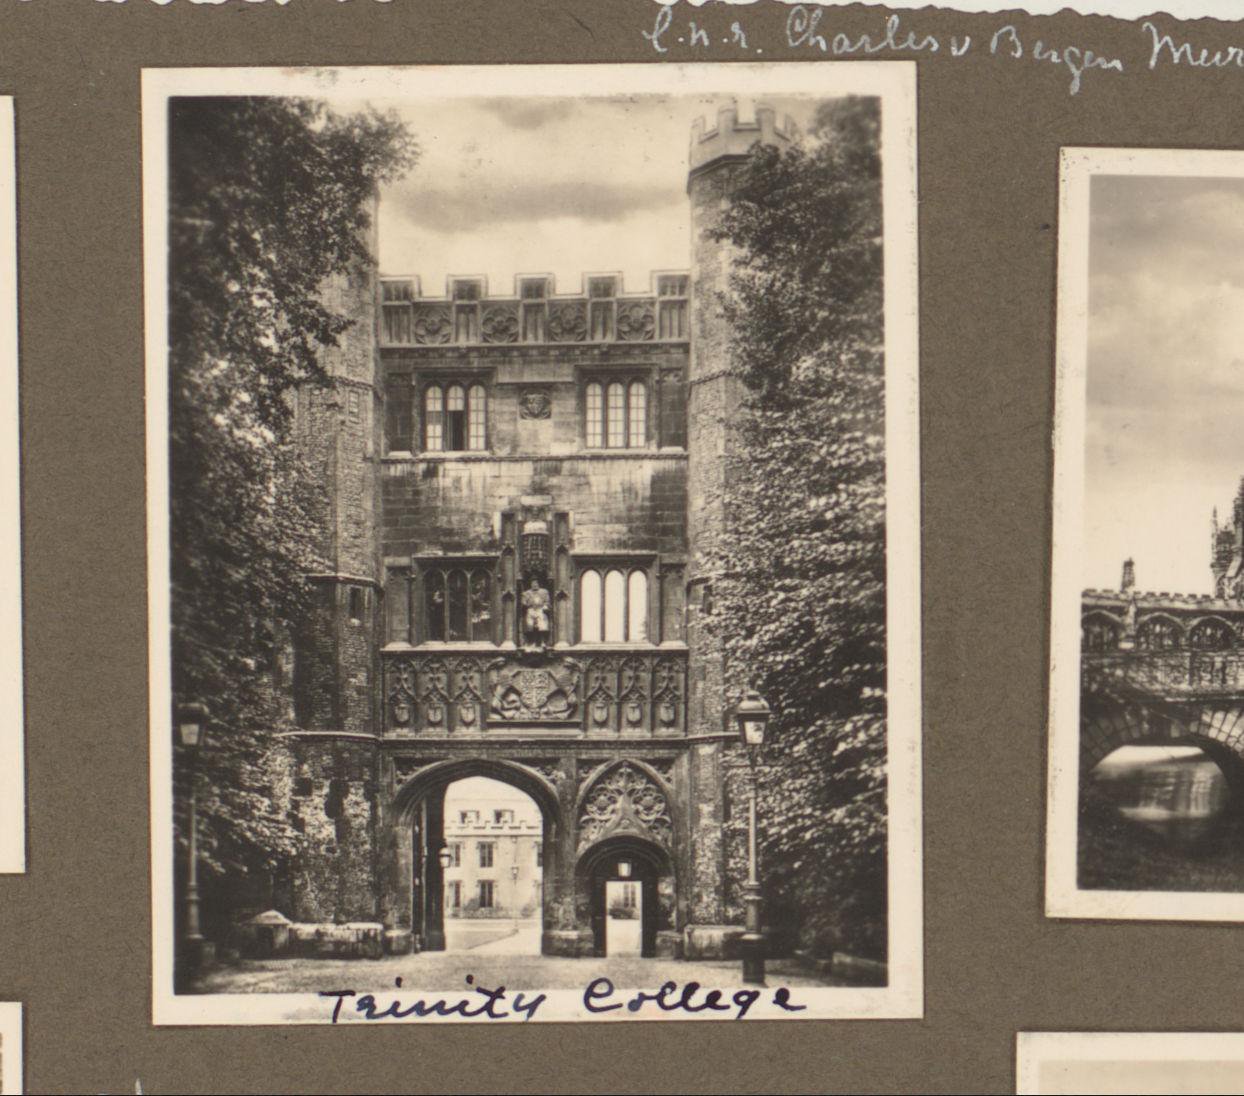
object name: photograph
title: Poort van Trinity College, Cambridge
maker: Anonymous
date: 1932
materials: paper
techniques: gelatin silver print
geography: cambridge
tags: gate, entrance, university building, college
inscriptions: inscription: ‘Trinity College’, inscription: ‘Degree-day in/ Cambridge’